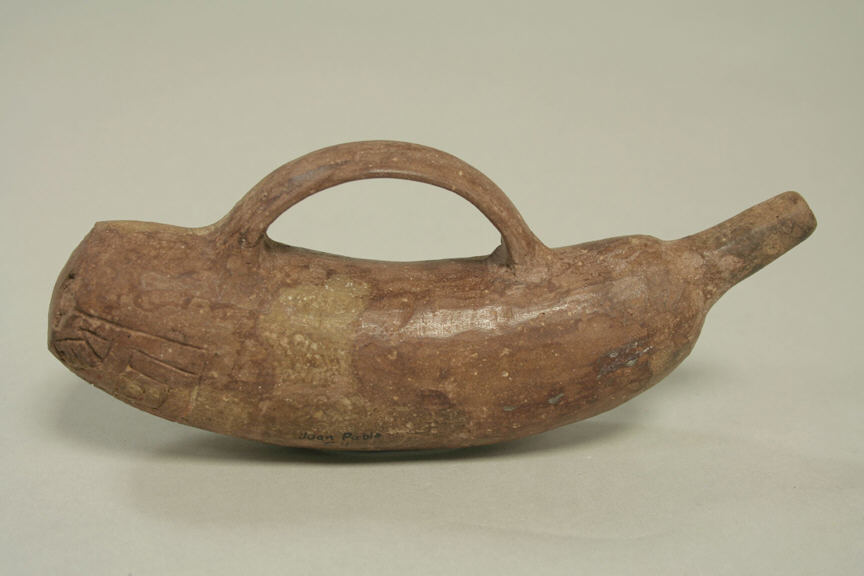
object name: bottle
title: Whistling bottle with single spout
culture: paracas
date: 500-201 BCE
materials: ceramic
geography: peru